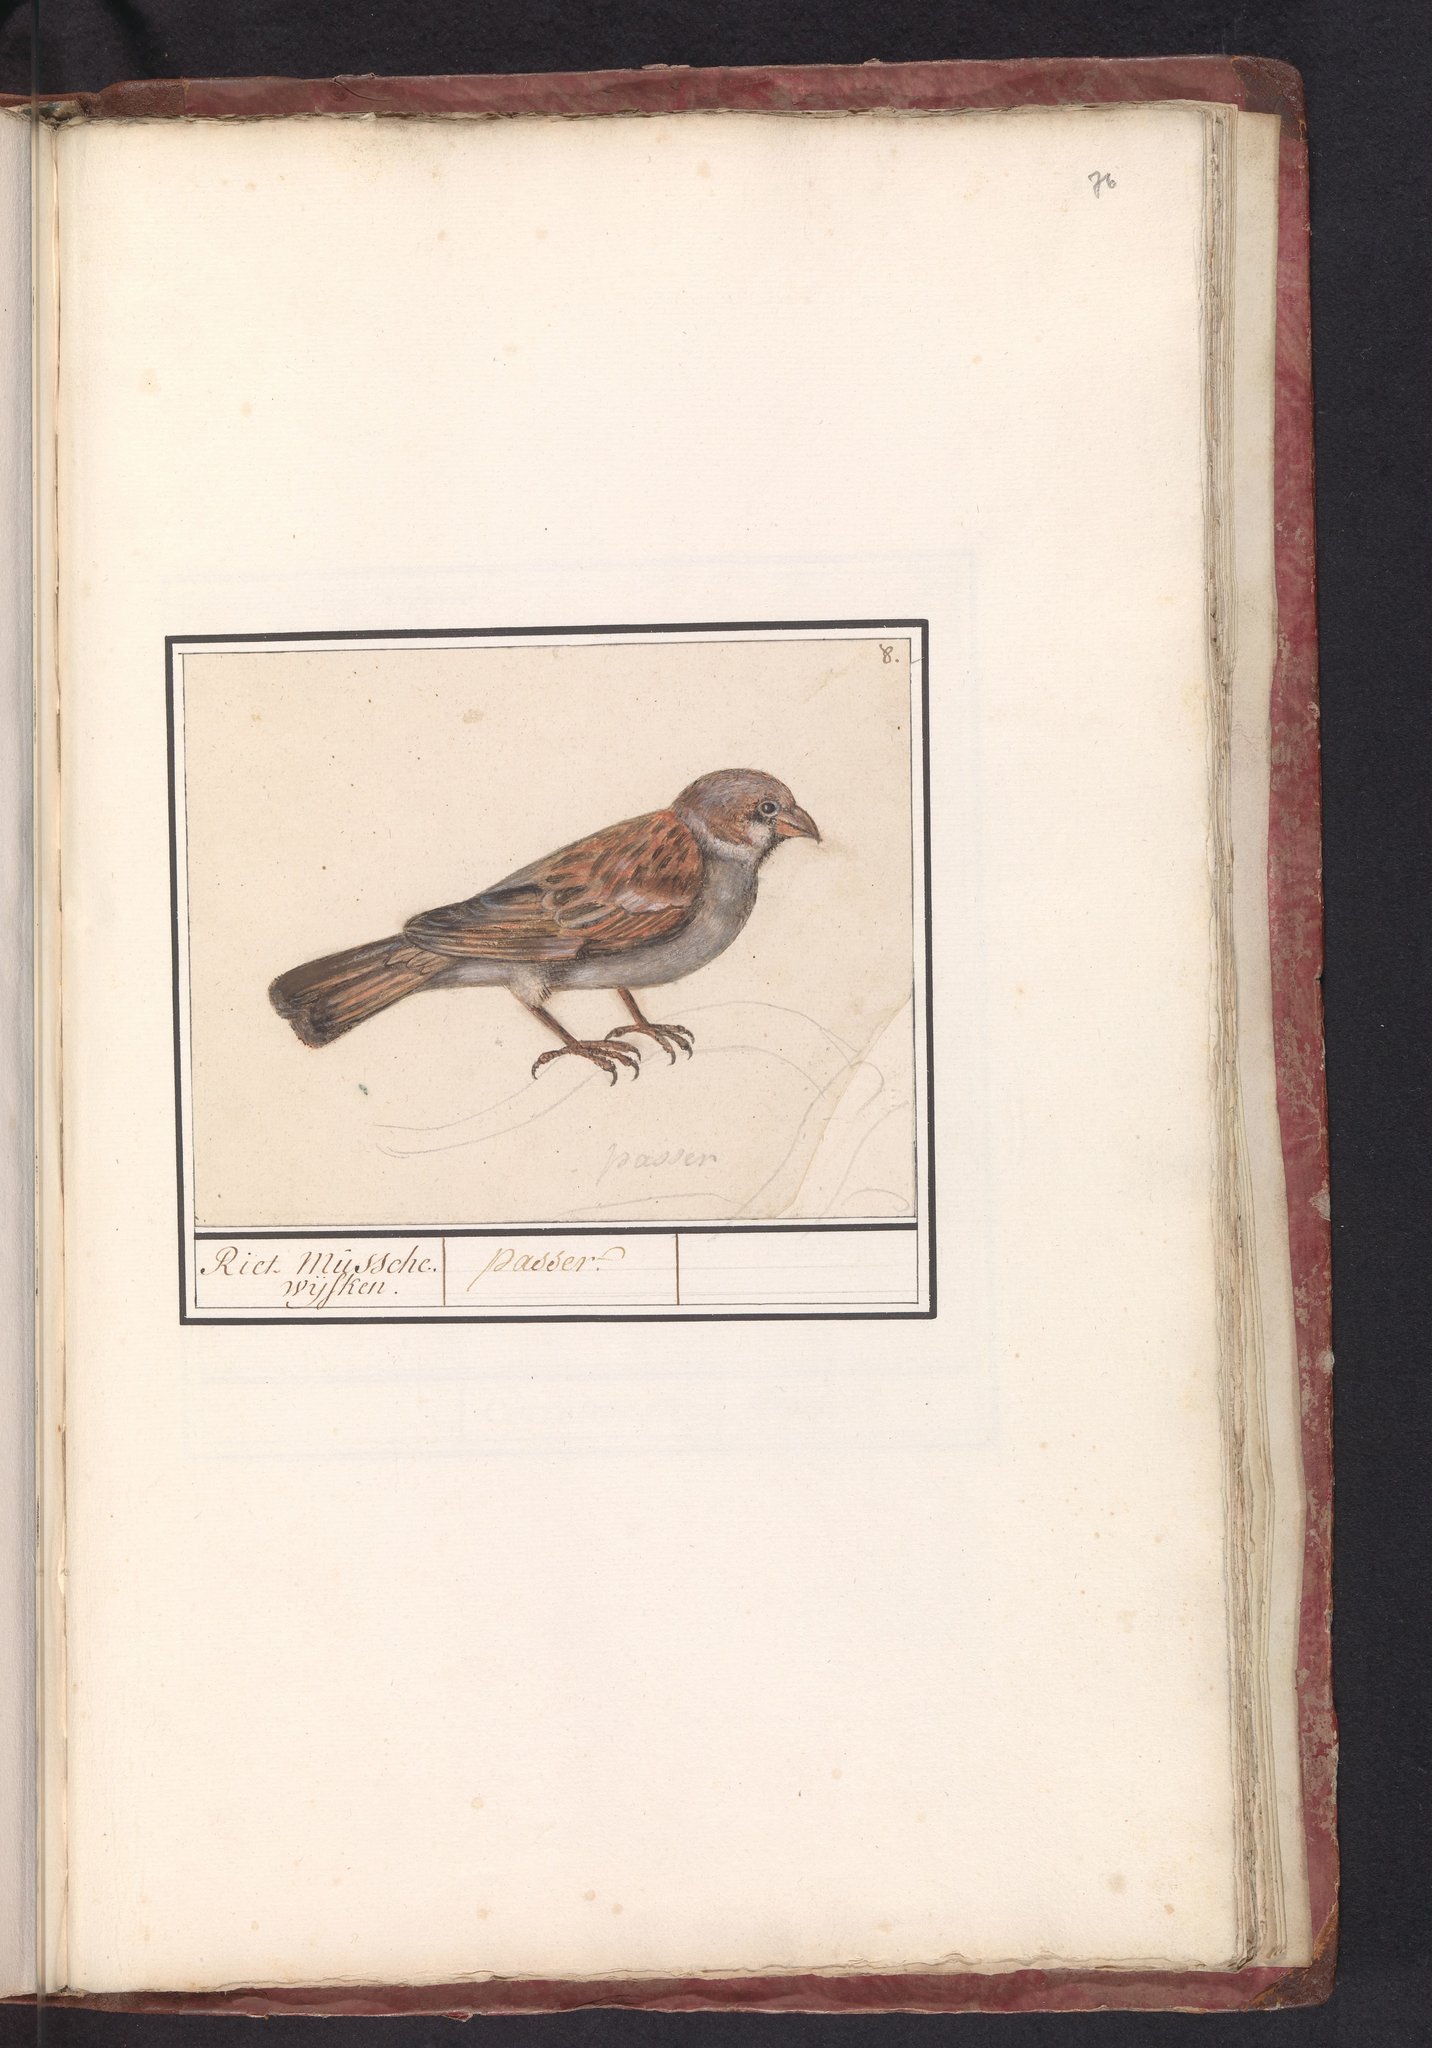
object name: drawing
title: Reed Bunting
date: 1596-1610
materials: paint, paper, pencil, watercolor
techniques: brush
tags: song-birds: reed bunting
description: Rietgors. Genummerd rechtsboven: 8. Onderdeel van het eerste album met tekeningen van vogels. Derde van twaalf albums met tekeningen van dieren, vogels en planten bekend rond 1600, gemaakt in opdracht van keizer Rudolf II. Met toelichting in Nederlands, Latijn en Frans.